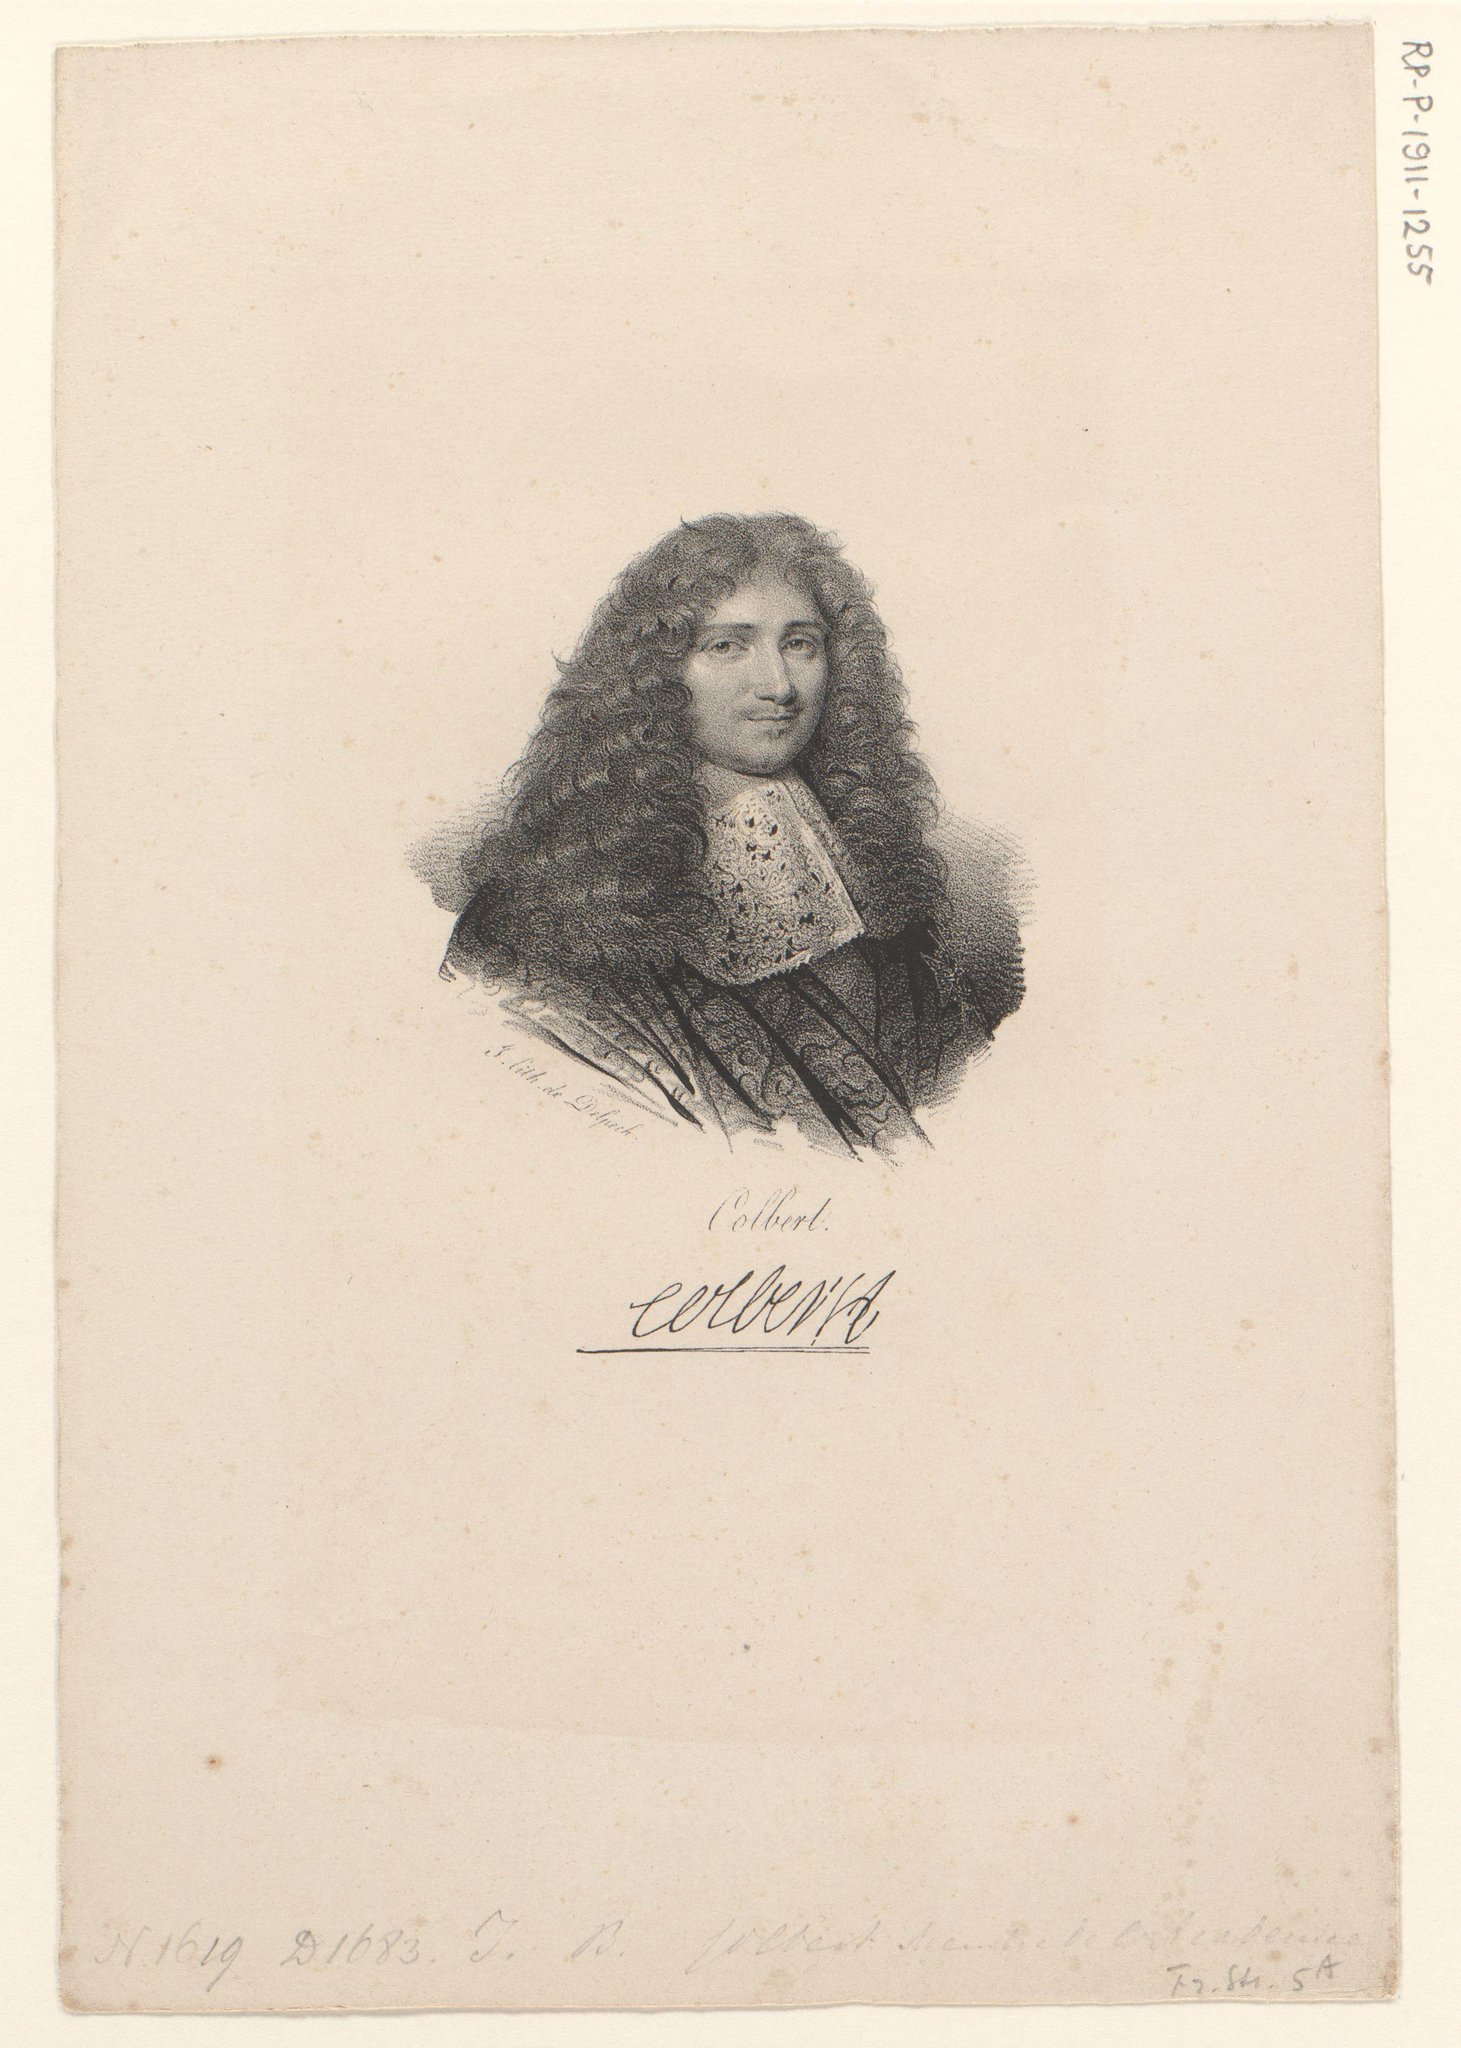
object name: print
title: Colbert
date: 1818-1842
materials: paper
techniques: lithograph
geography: paris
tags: politician, jean-baptiste colbert, historical persons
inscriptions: collector's mark: Lugt 2228a